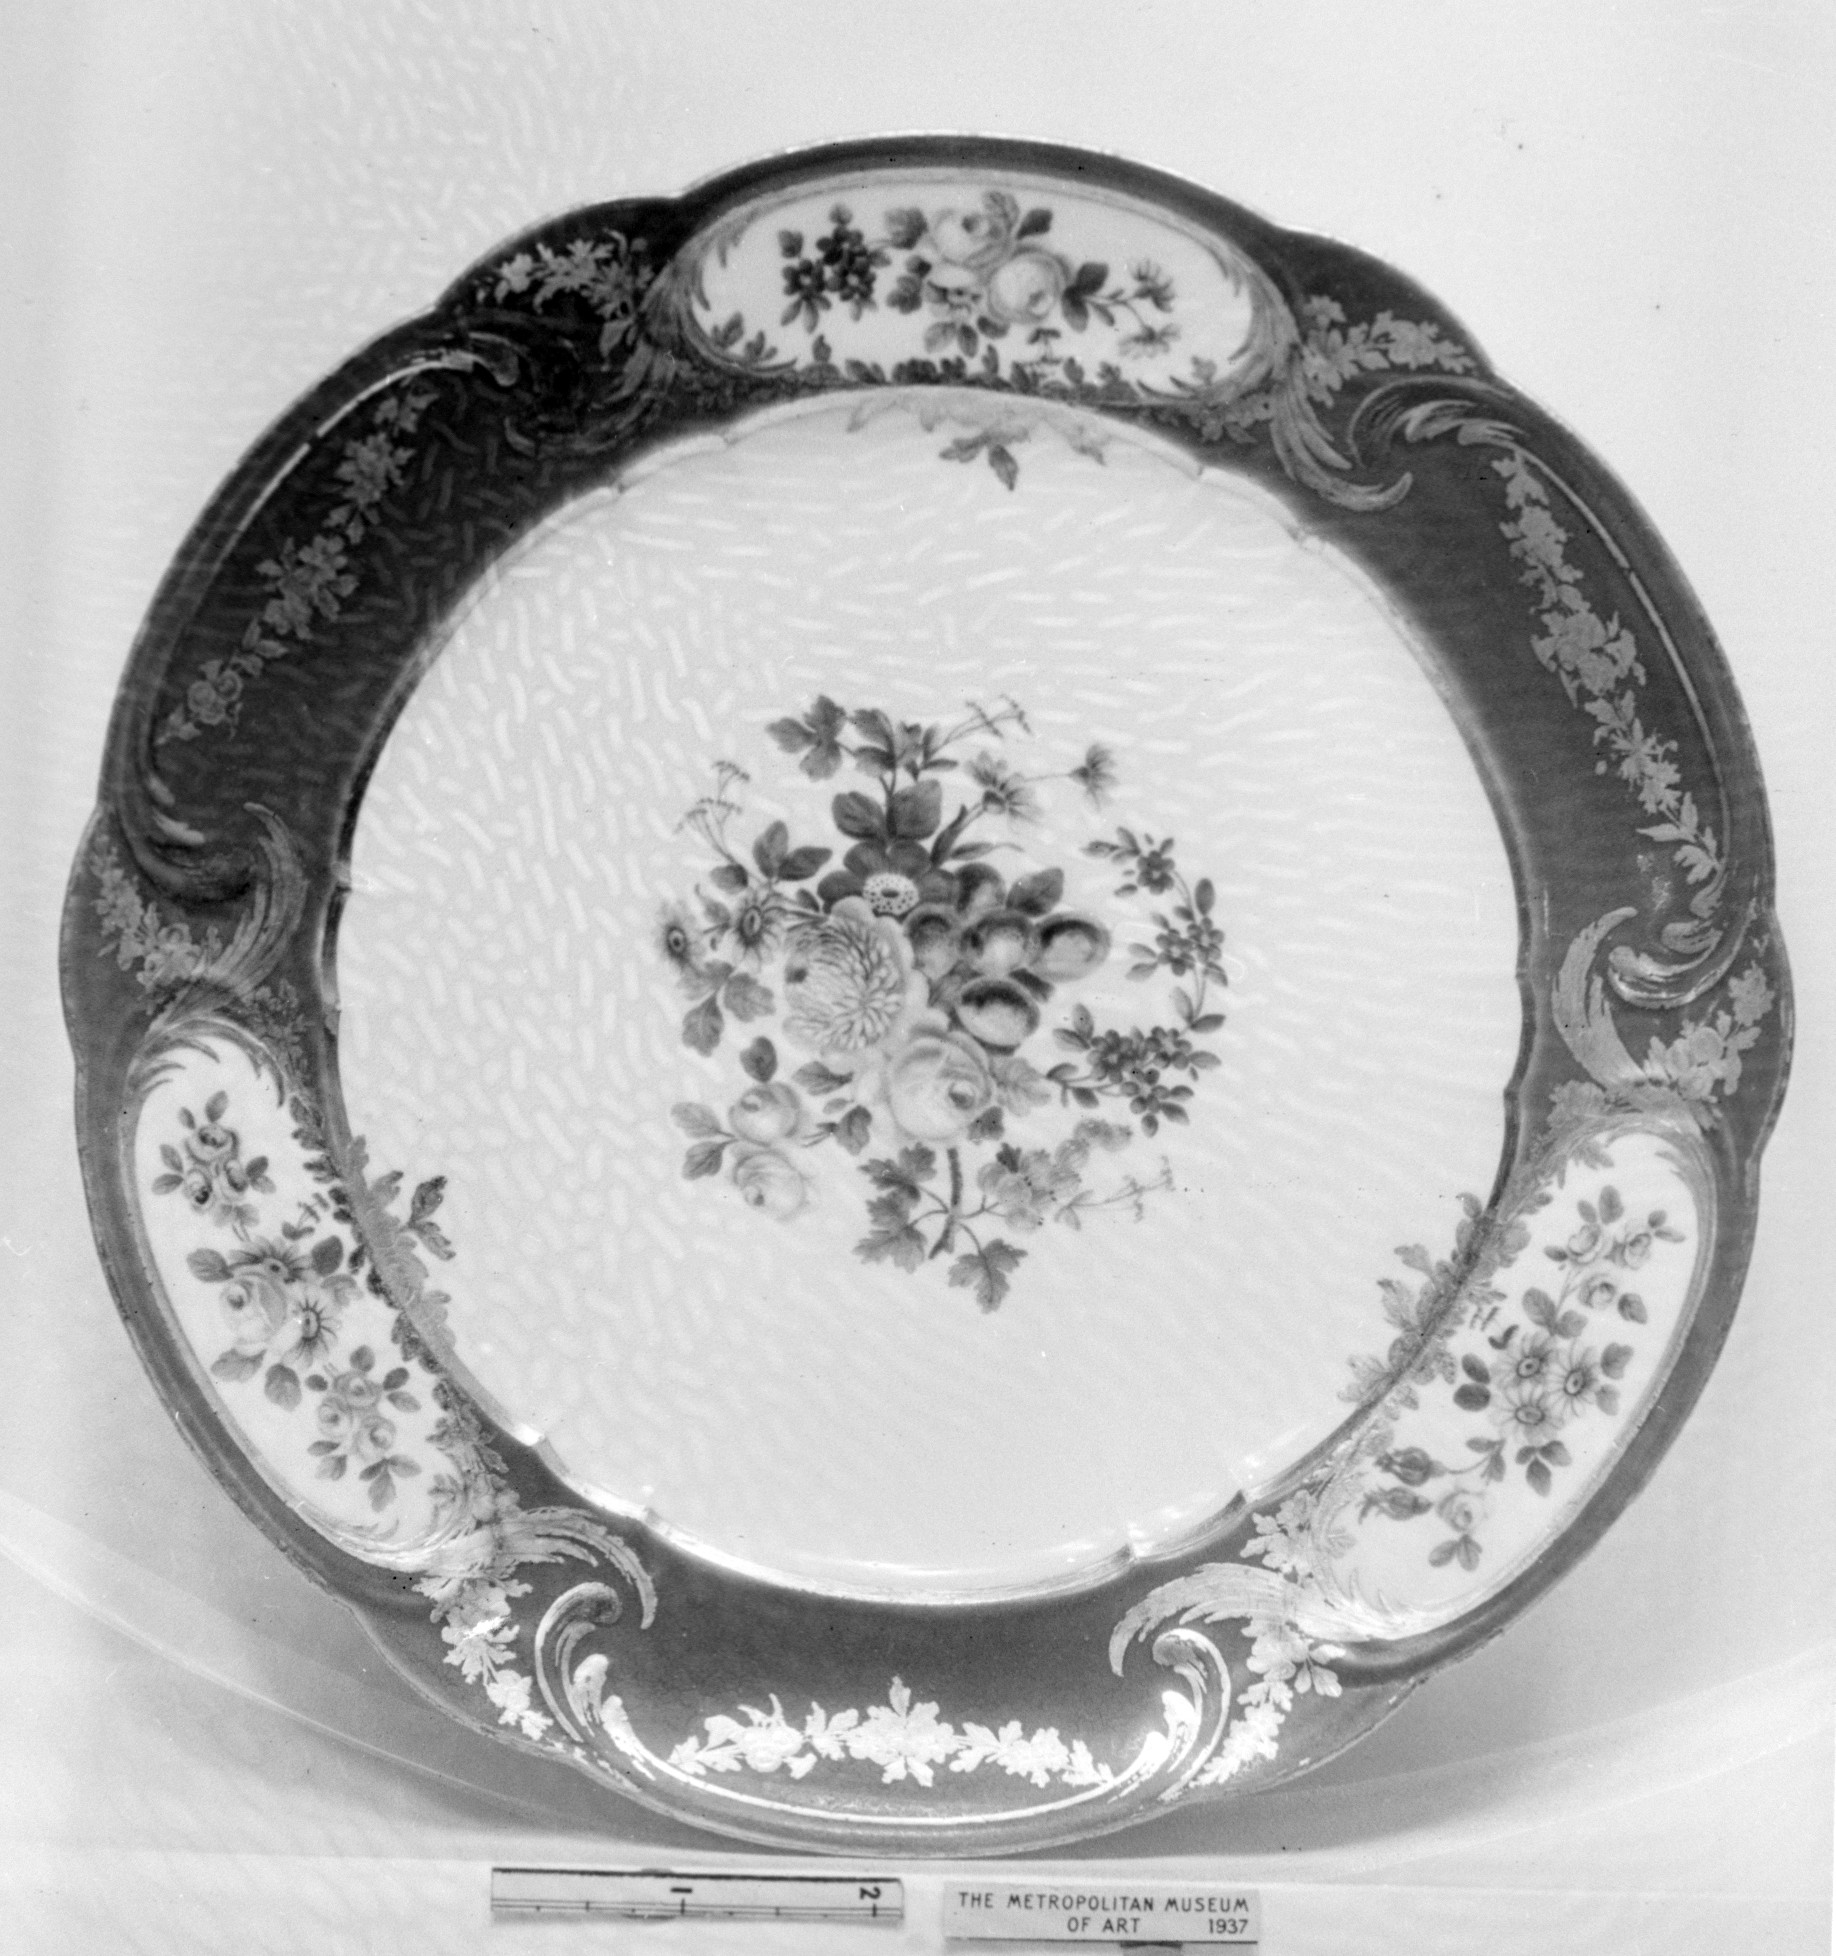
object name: plate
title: Plate (Assiette à palmes) (1 of 102) (part of a service)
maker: sèvres manufactory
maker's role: manufactory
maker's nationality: french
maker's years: 1740-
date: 1786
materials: soft paste porcelain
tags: flowers